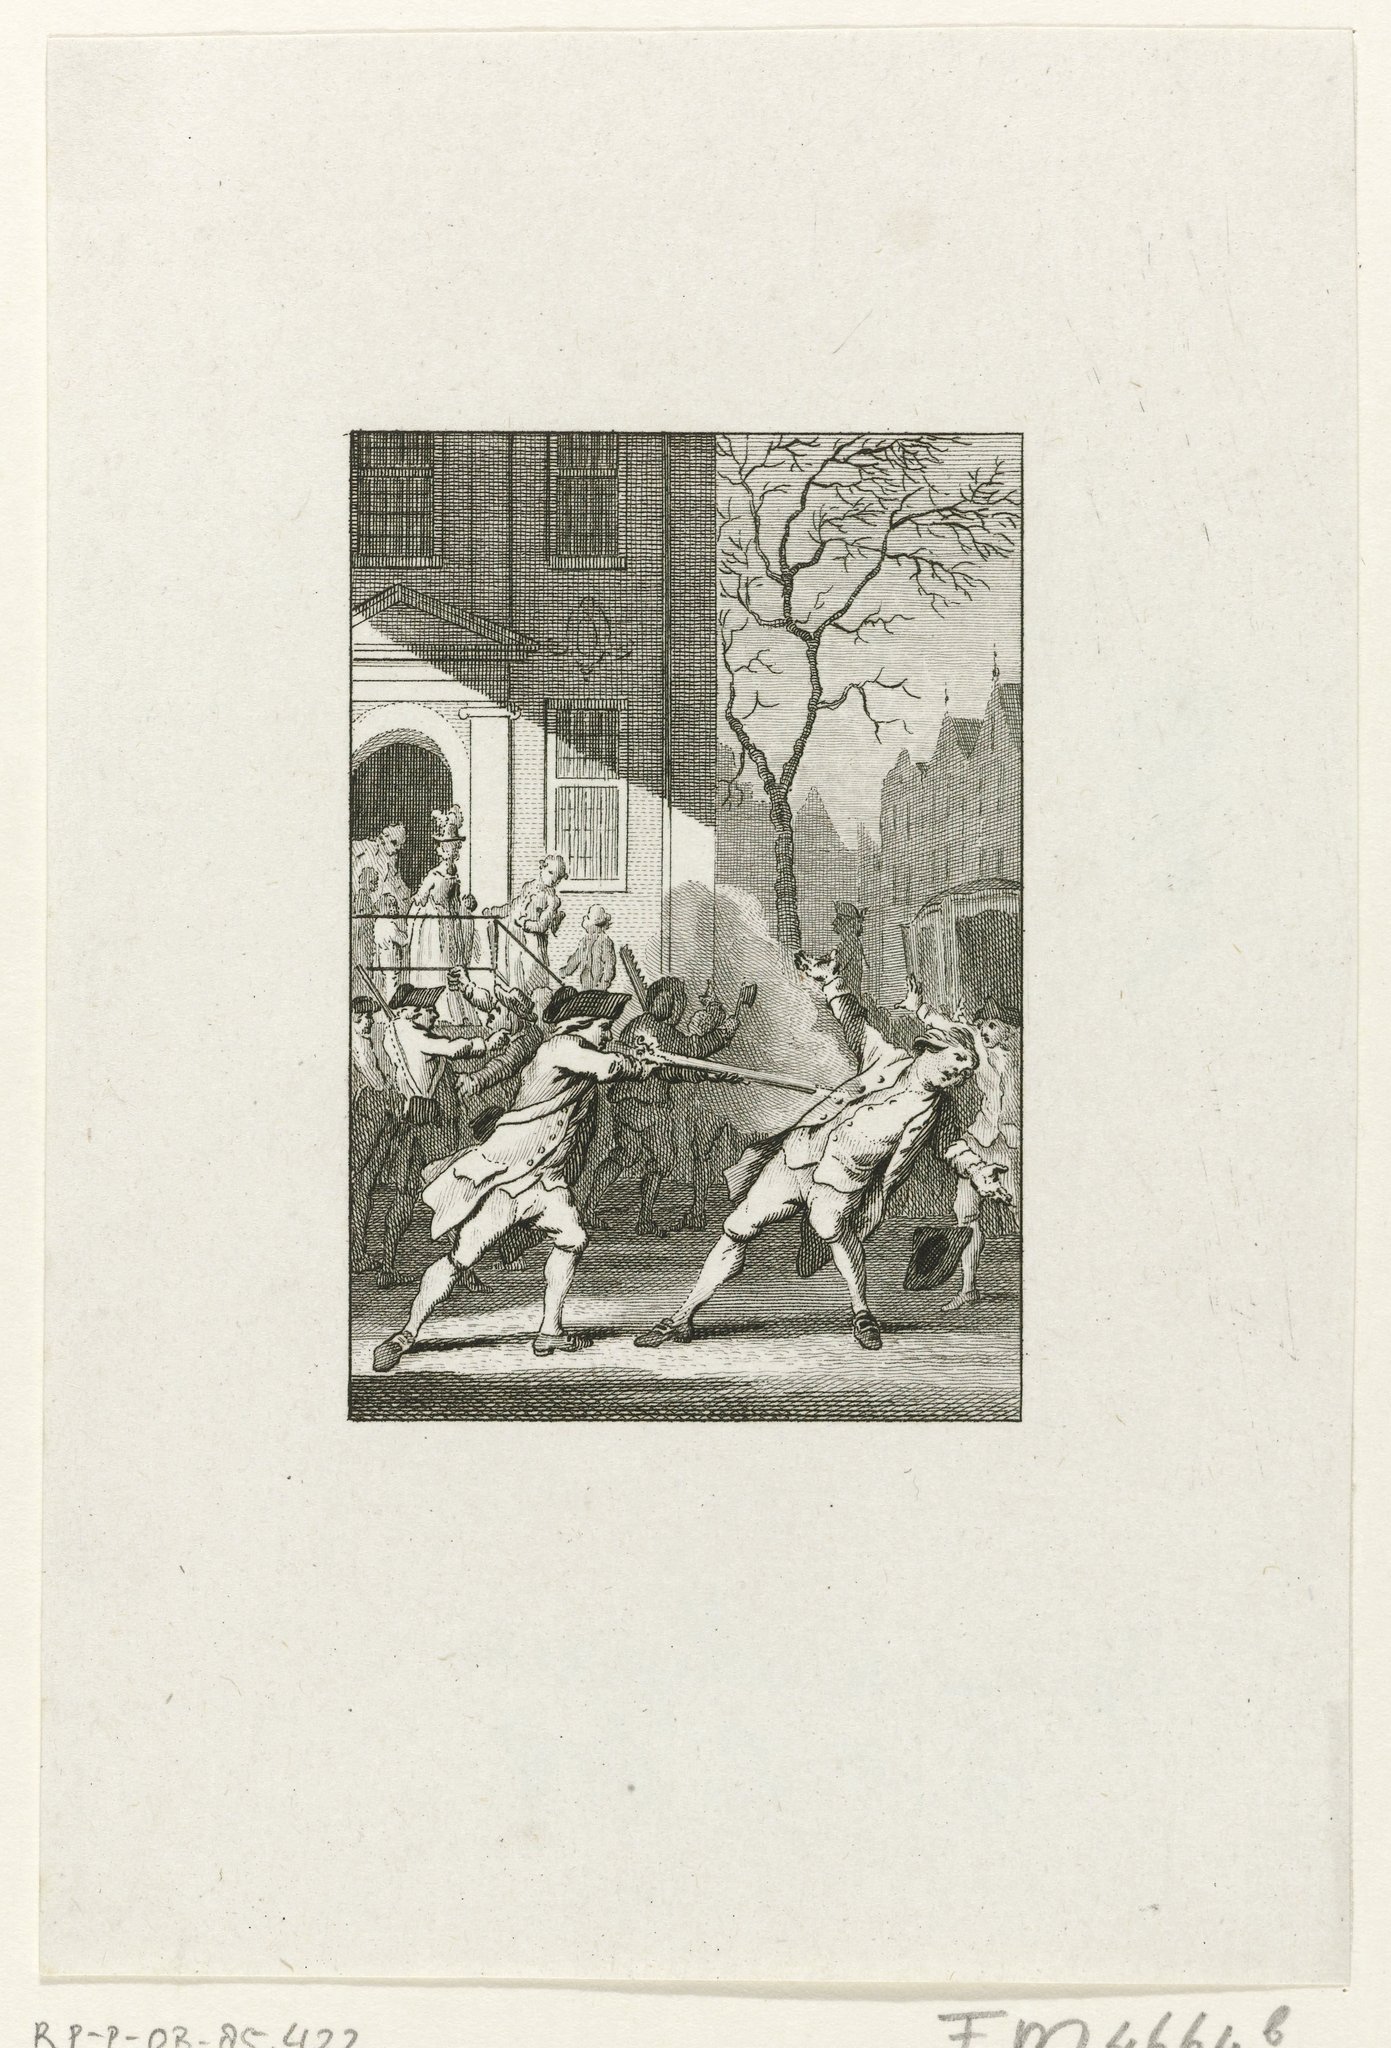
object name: print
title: Ongeregeldheden te Meppel, 1785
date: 1785-1795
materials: paper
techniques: engraving, etching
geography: northern netherlands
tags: street-fights, riots, patriots (1780-1795)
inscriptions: collector's mark: Lugt 2228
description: Gebruikt als illustratie in: J. Fokke, Geschiedenissen der Vereenigde Nederlanden voor de vaderlandsche jeugd, Johannes Allart, Amsterdam 1783-1795, 25 delen, dl. 15, pl. 11.